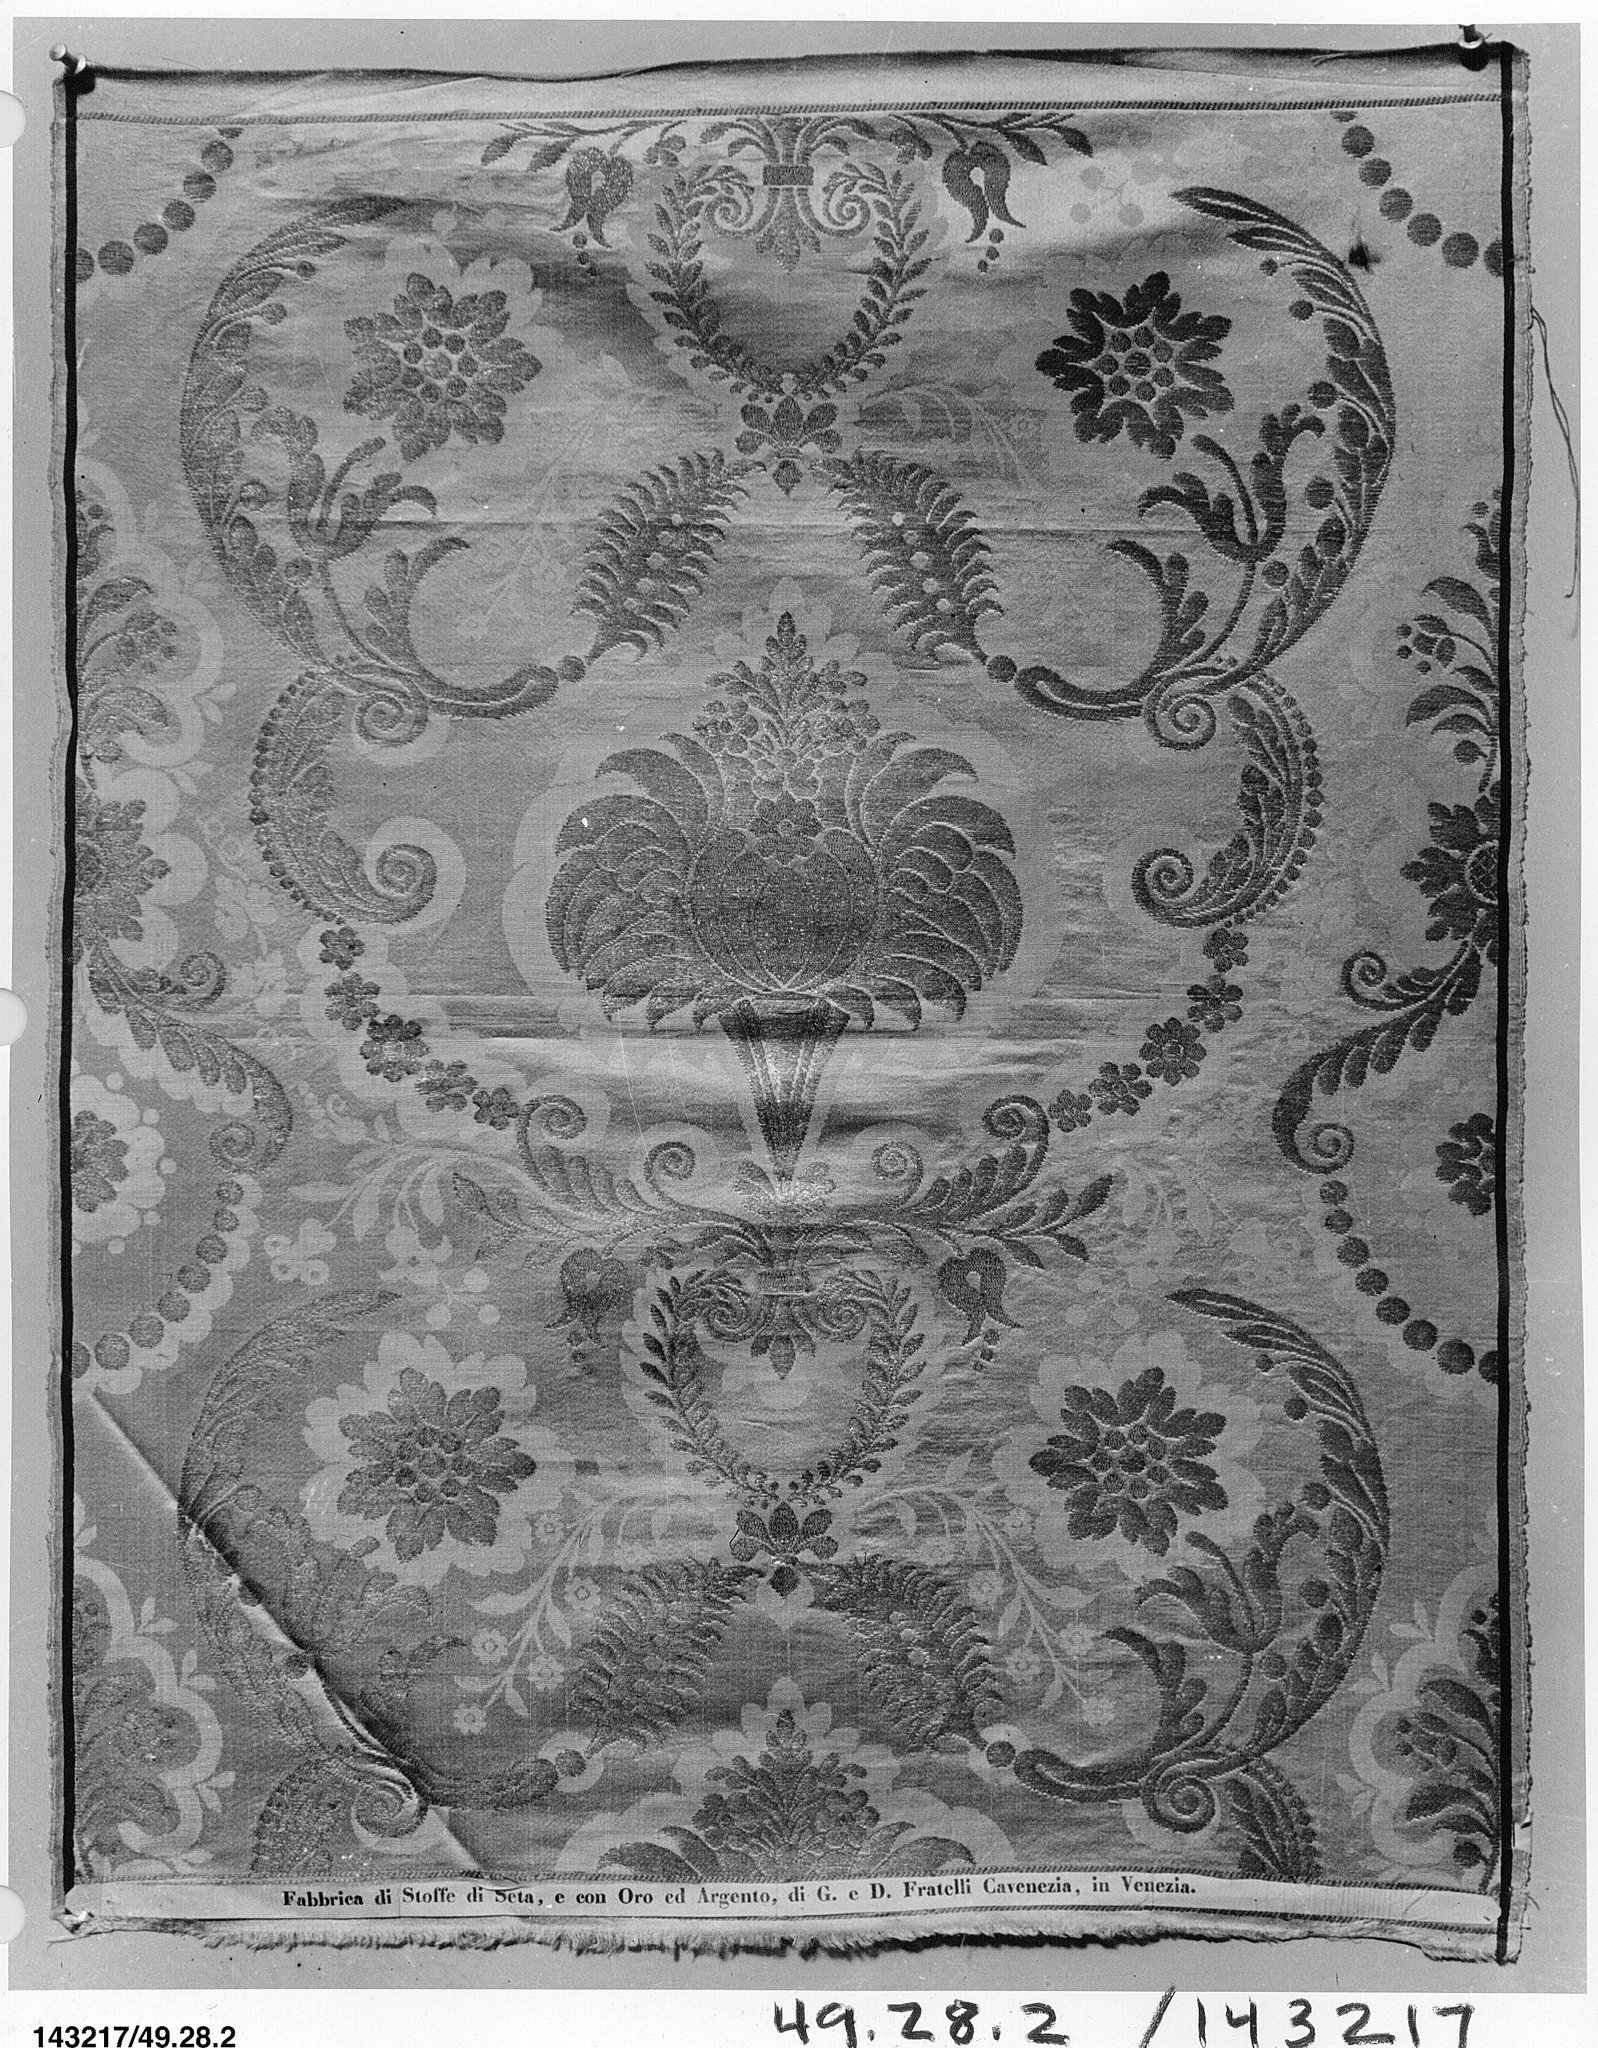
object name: panel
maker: cavenezia workshop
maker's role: manufactory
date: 1801-1833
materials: metal thread, silk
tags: flowers